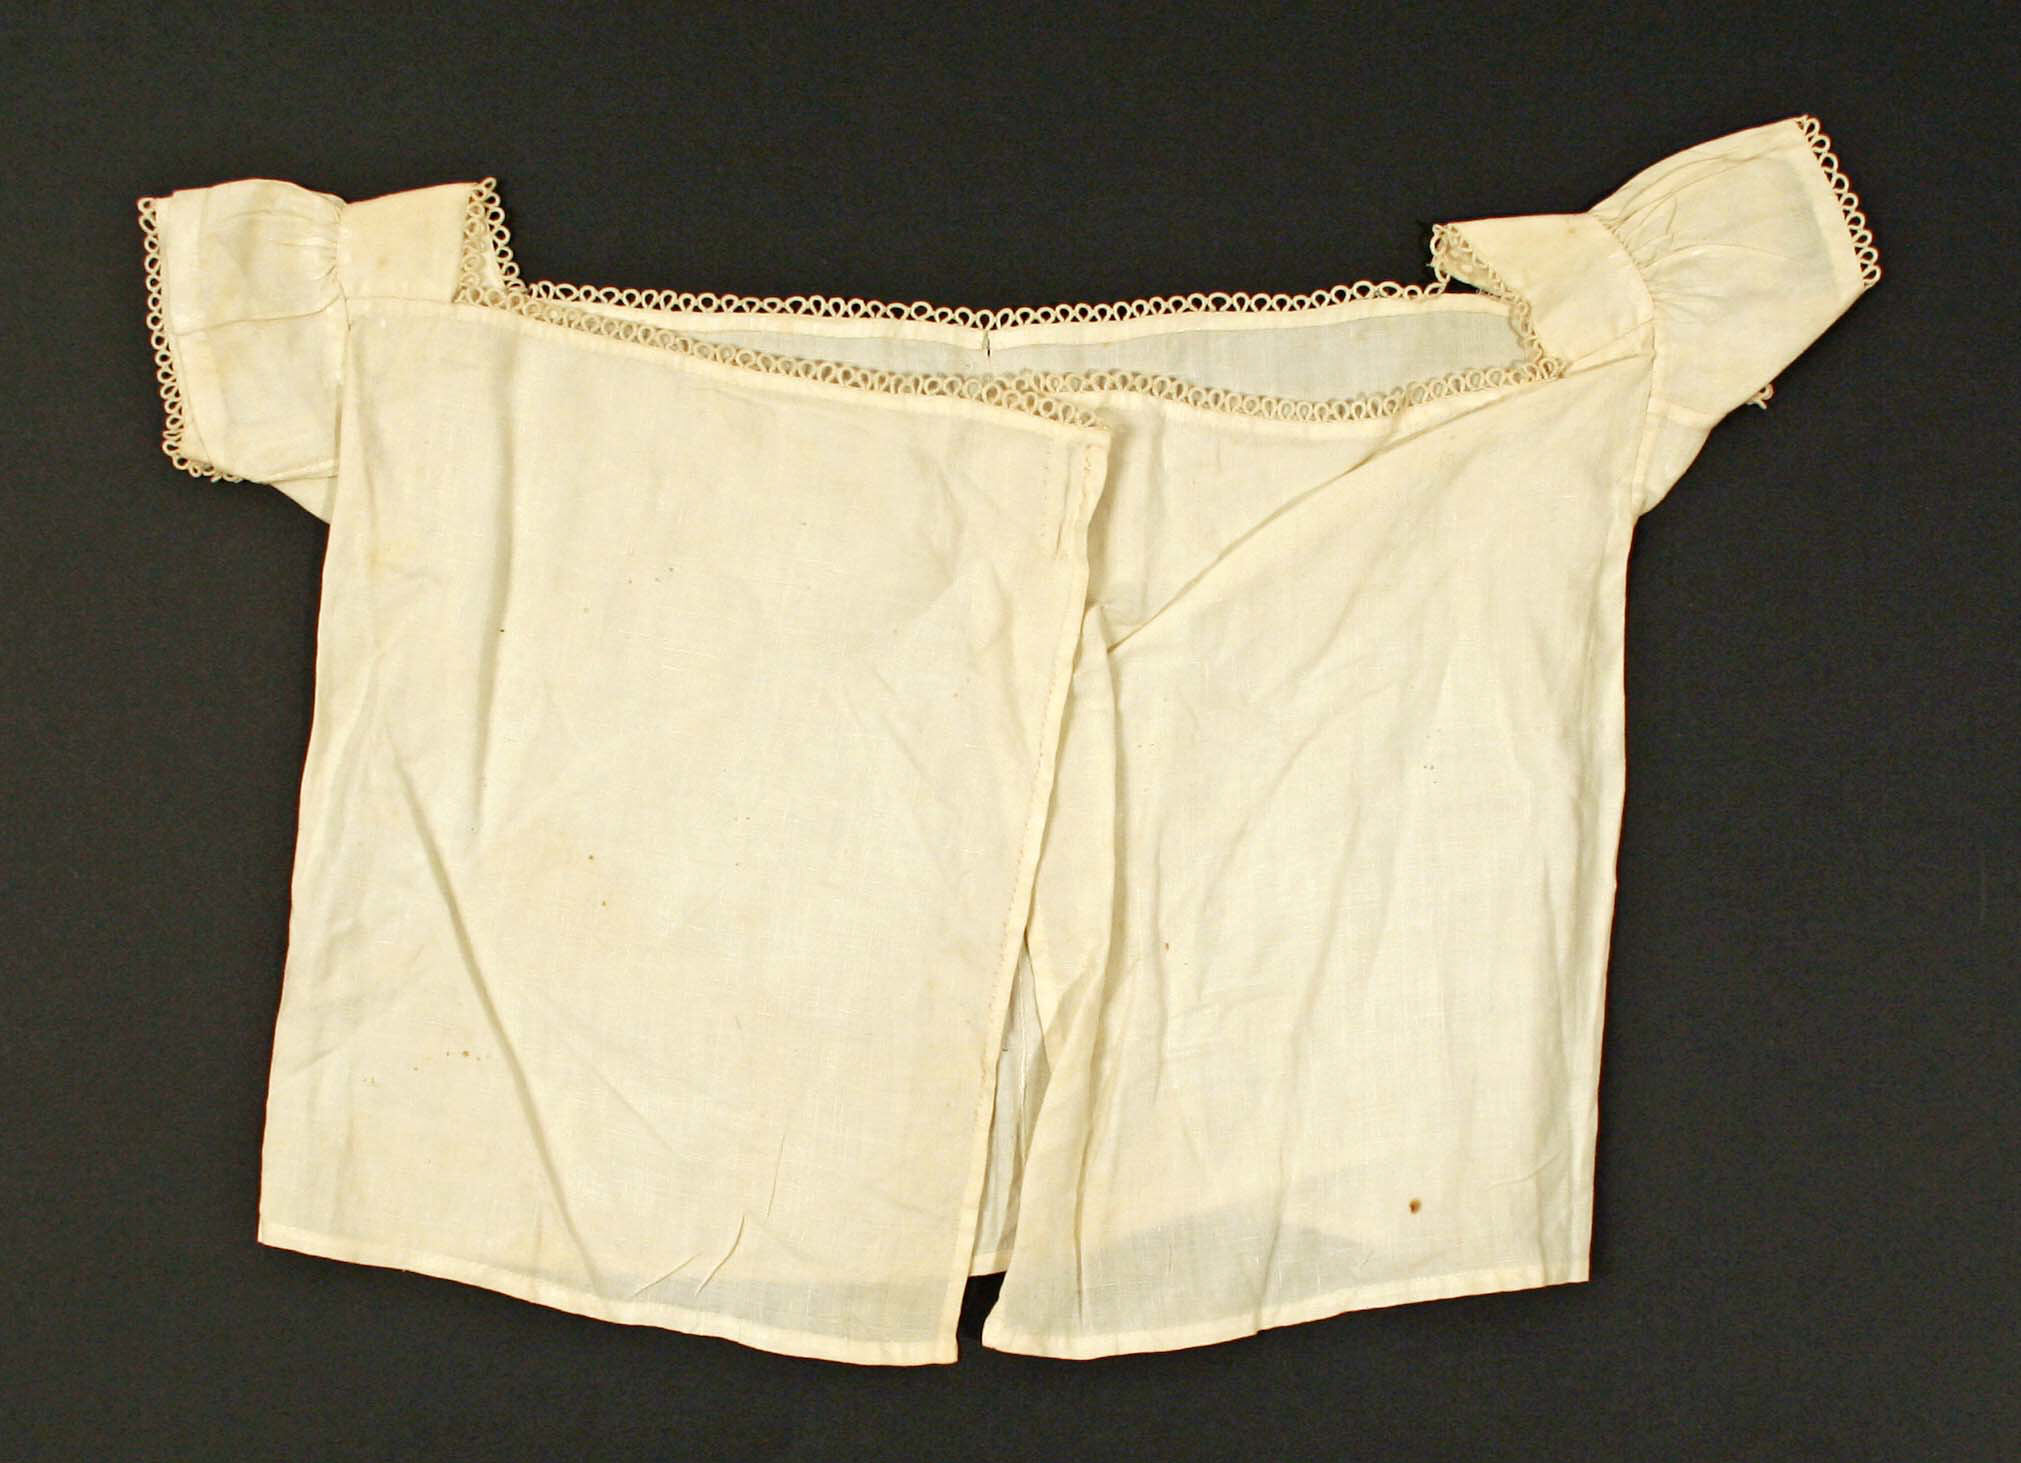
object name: waist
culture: american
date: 1855-1865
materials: linen